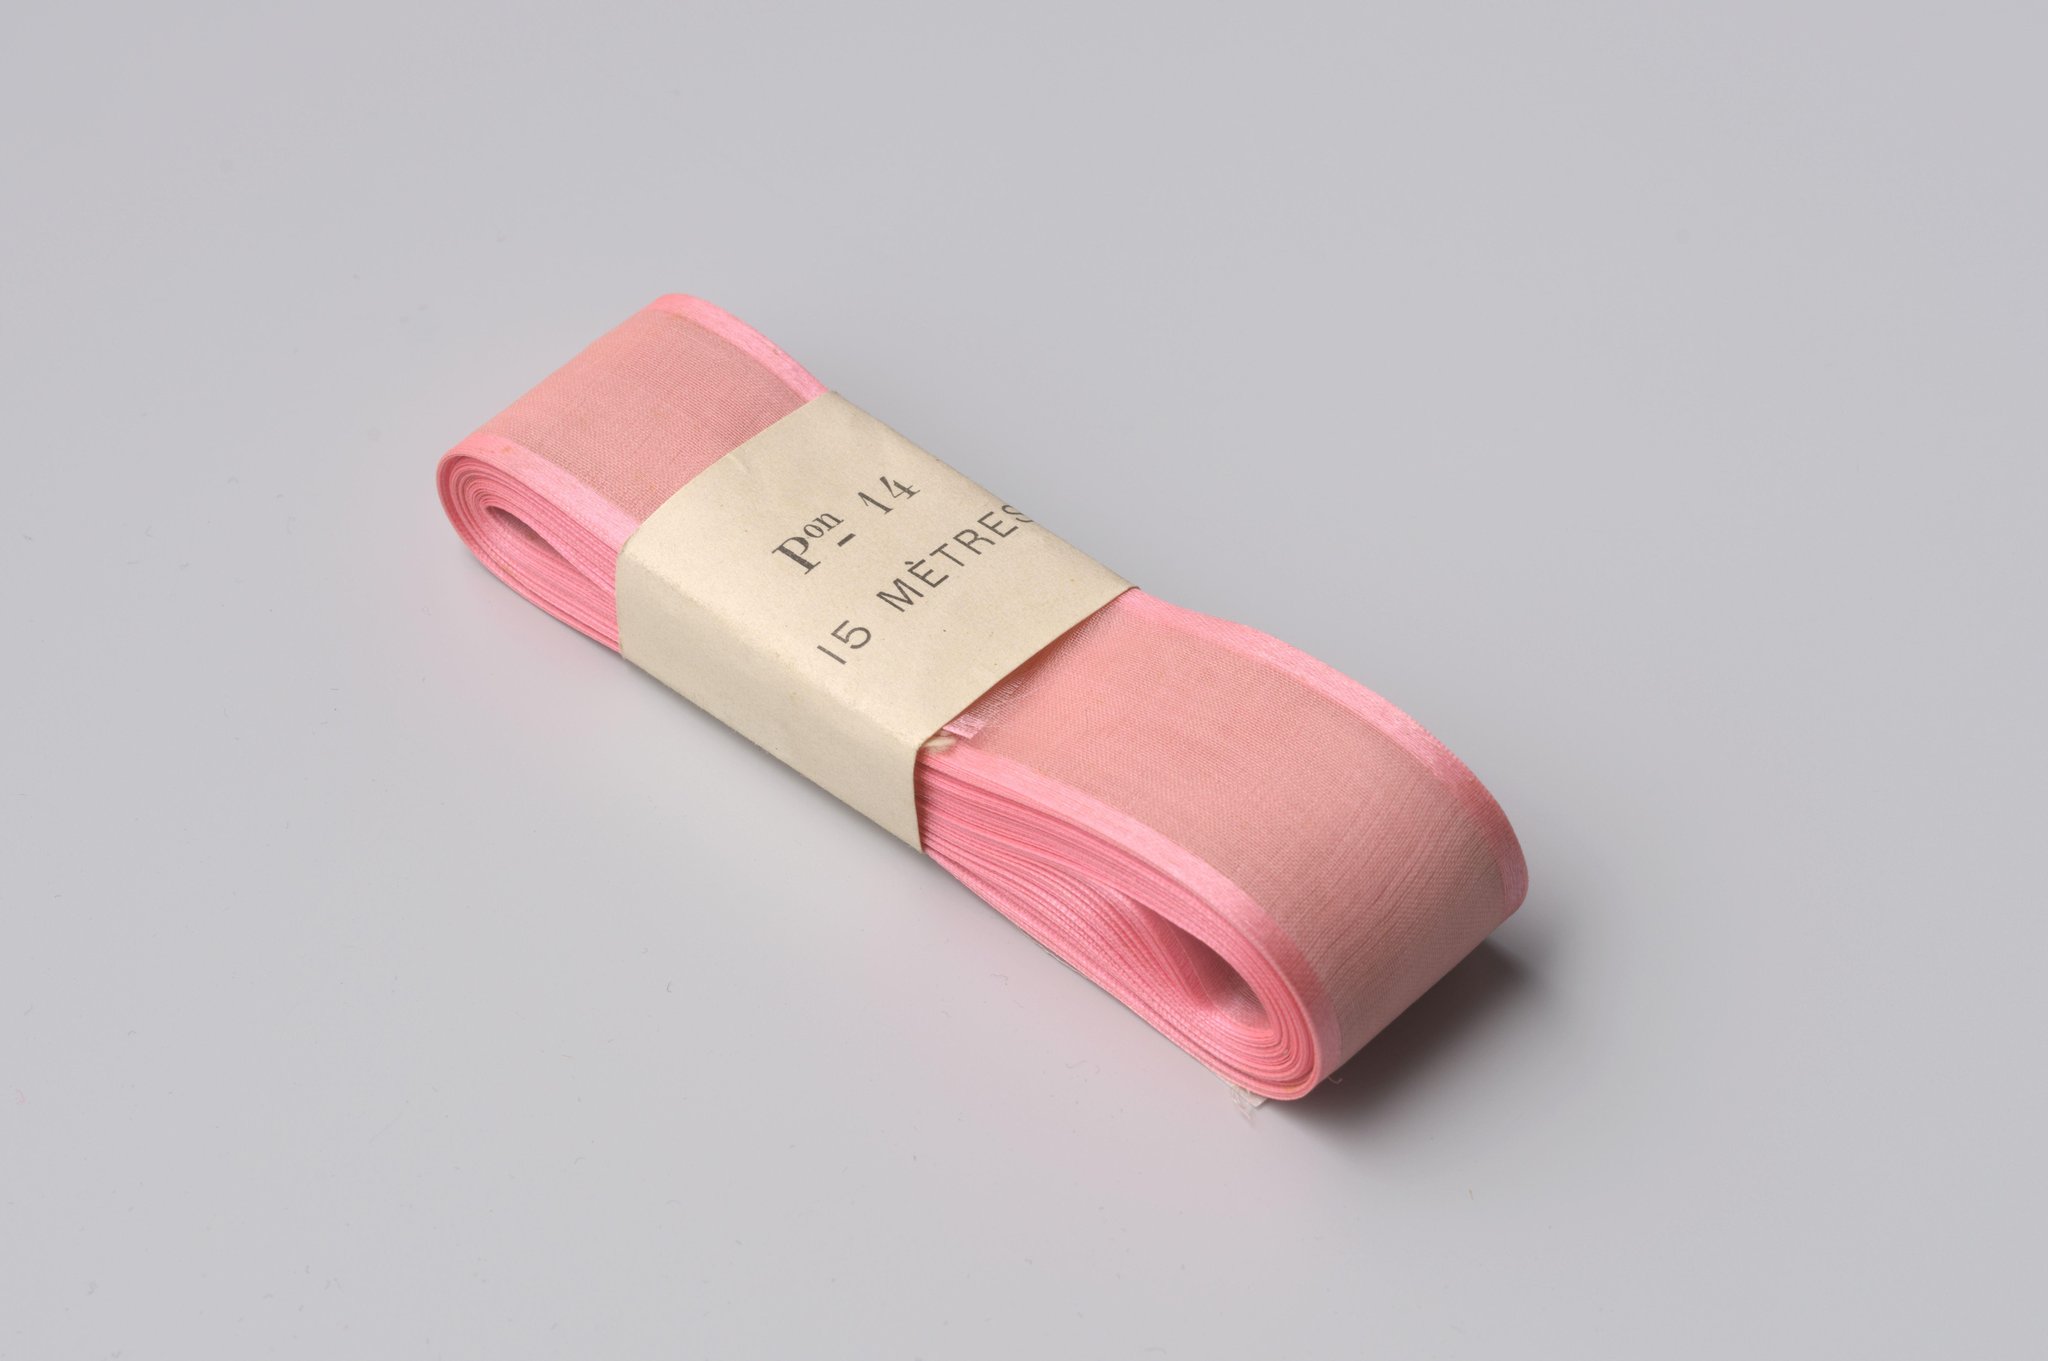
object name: braid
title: Lint van roze gaas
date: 1900-1915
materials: textile, silk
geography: france